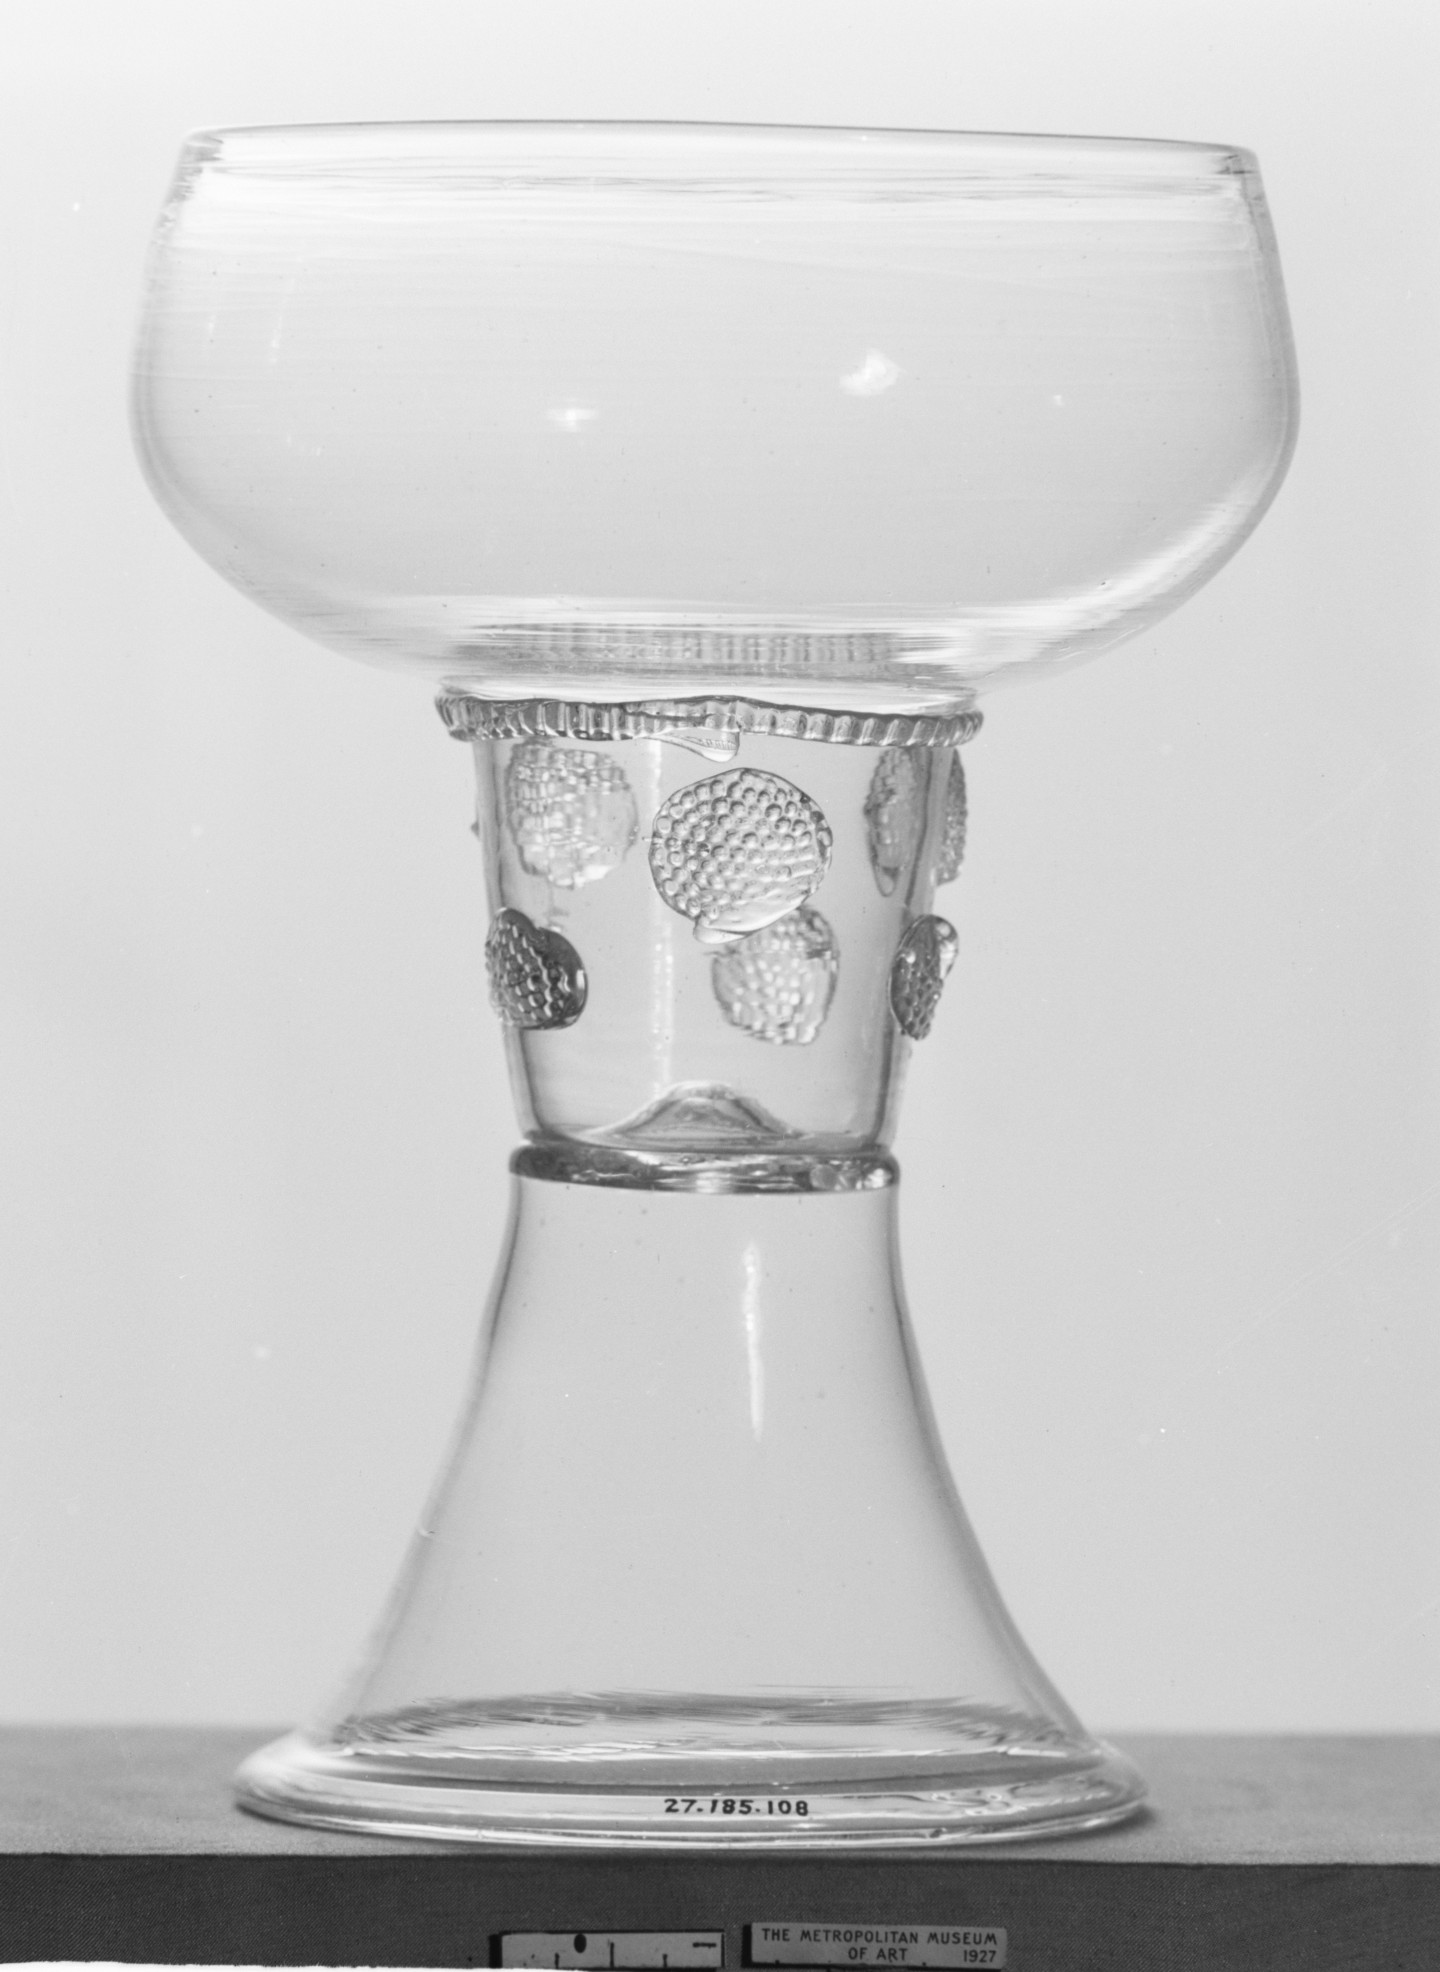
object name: goblet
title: Goblet (Roemer)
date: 1601-1800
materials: glass